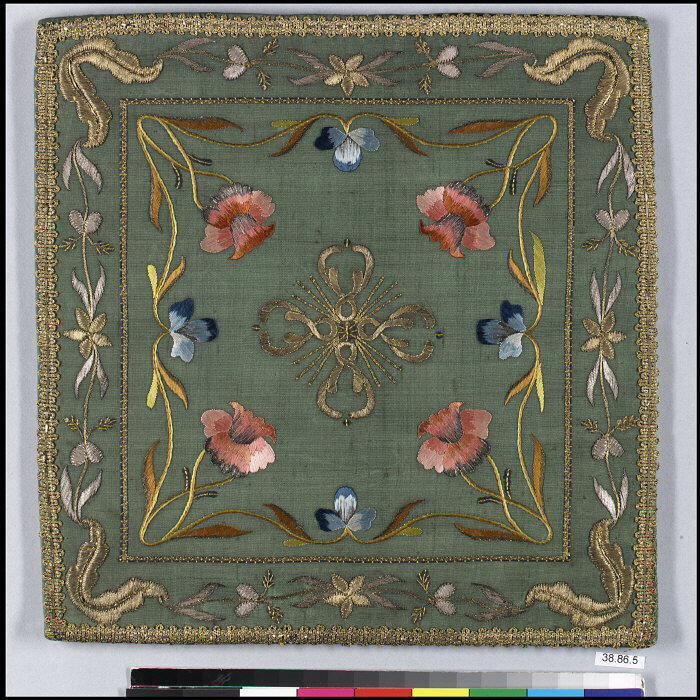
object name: burse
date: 1890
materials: metal thread, silk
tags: flowers